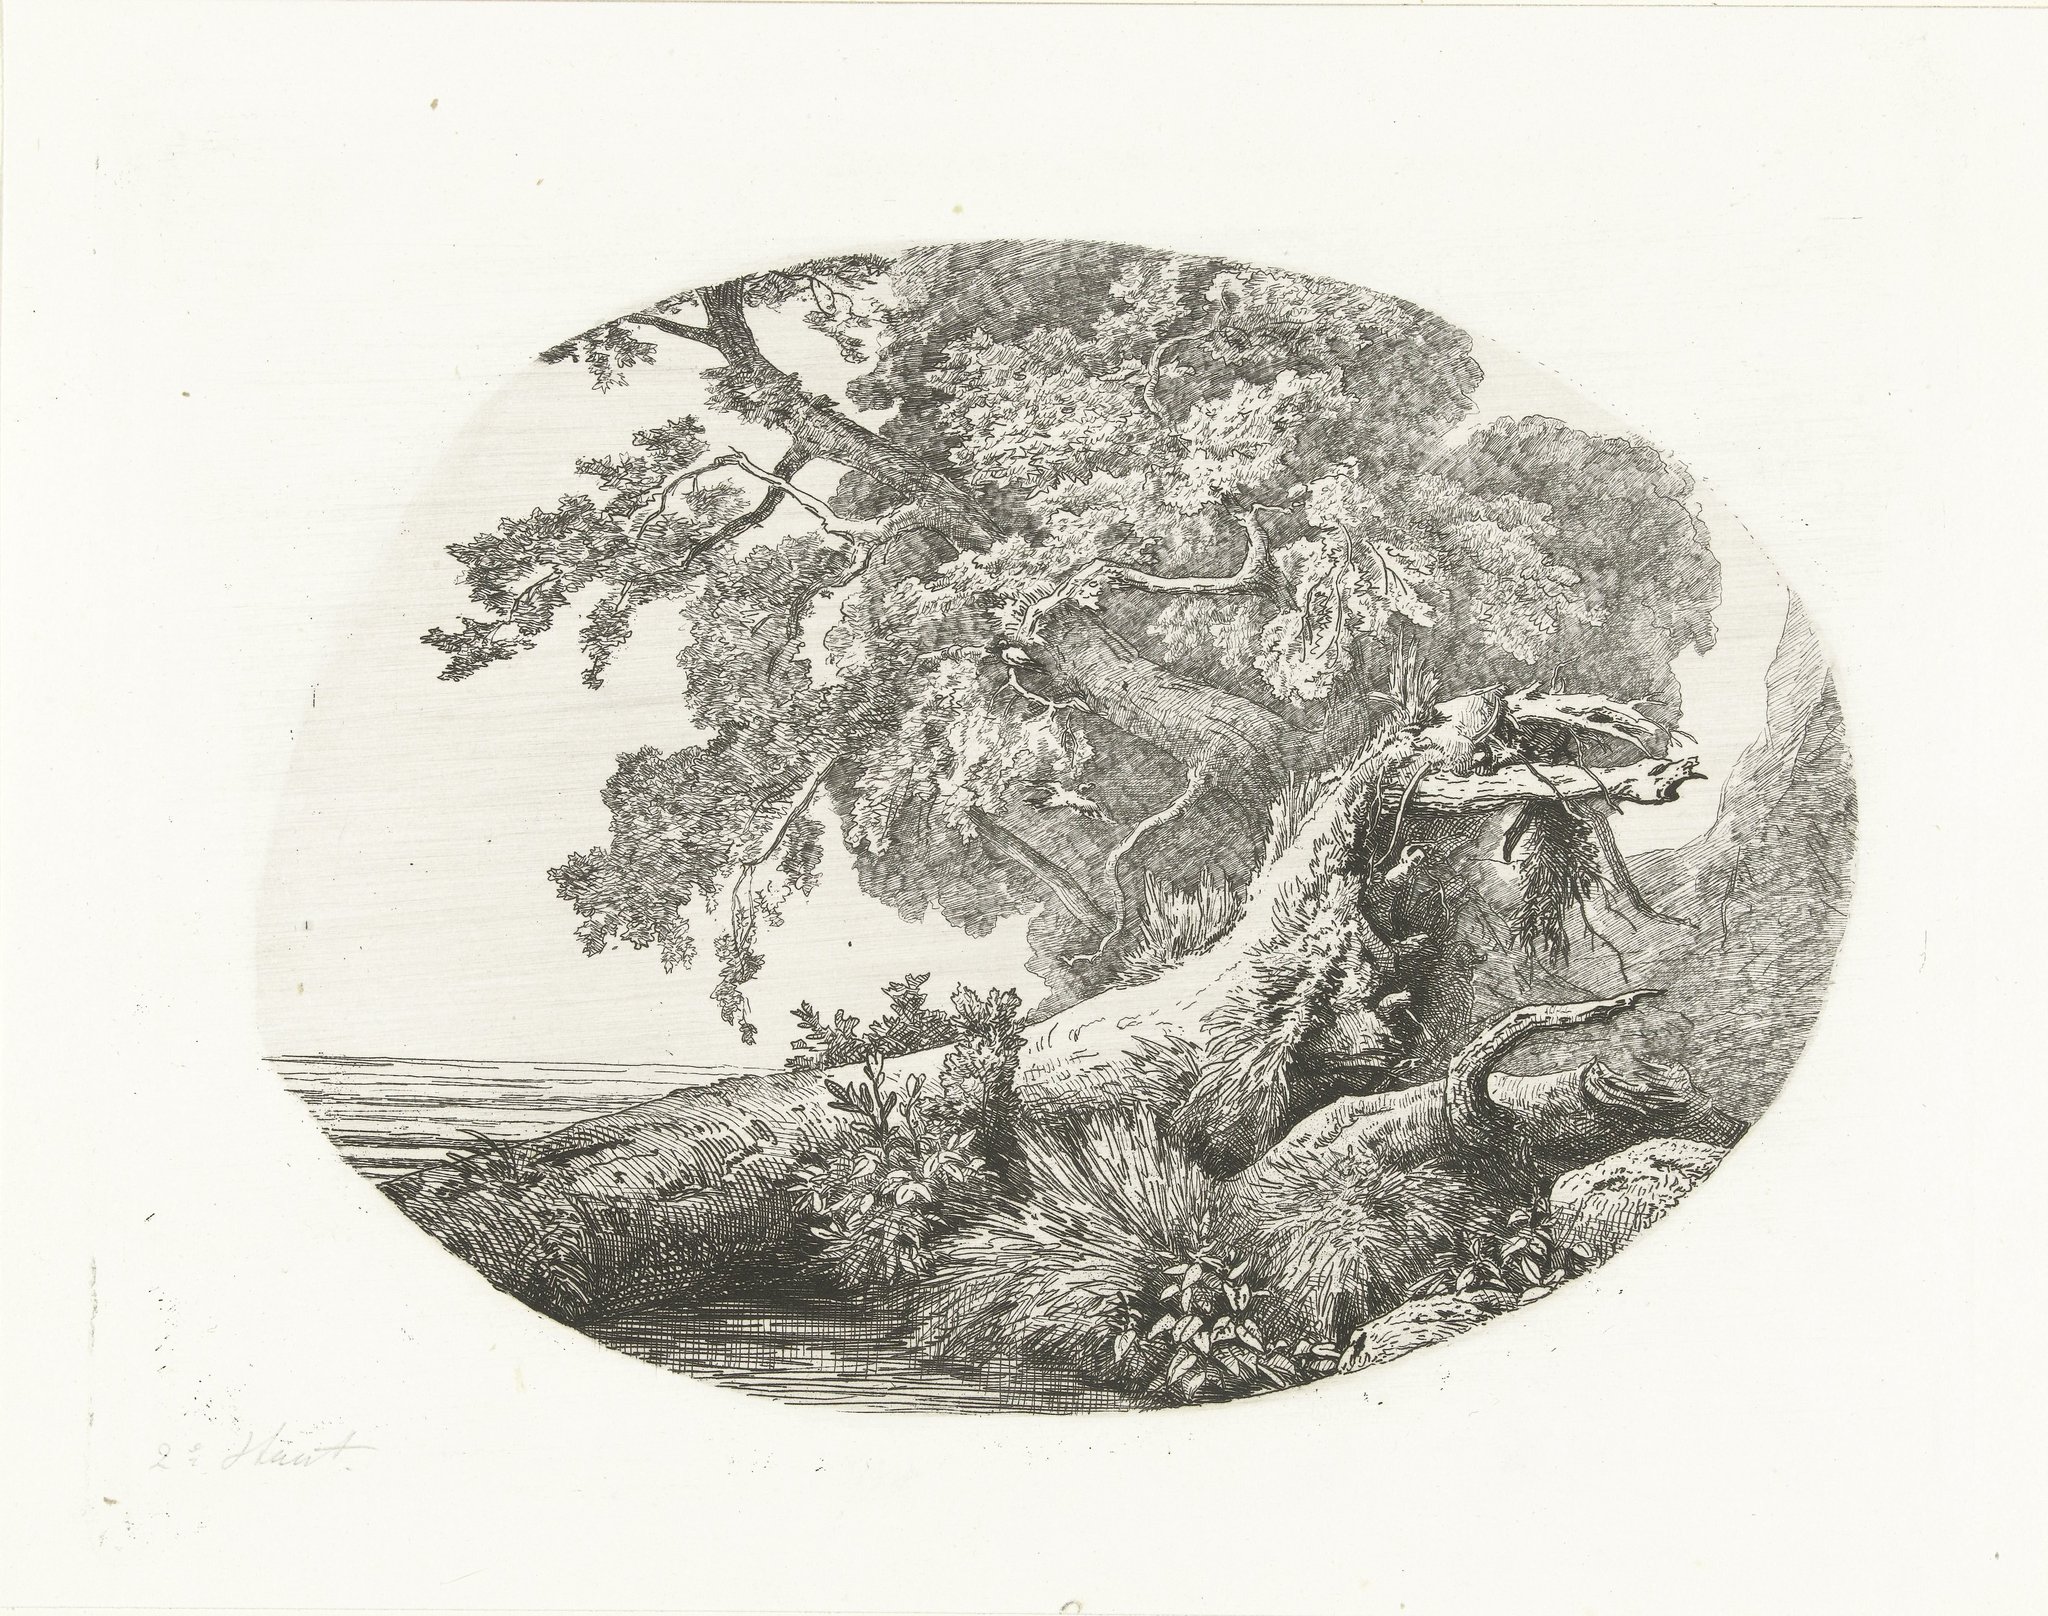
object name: print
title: Ontwortelde boomstam aan de kust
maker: pierre louis dubourcq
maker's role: draughtsman, painter, print maker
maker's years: 1815-1873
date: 1854-1856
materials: paper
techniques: etching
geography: netherlands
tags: groups of trees, mountain-range, snow peaks, coast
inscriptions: collector's mark: Lugt 2228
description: Aan de kust van een meer ligt een ontwortelde boomstam. Aan de overkant zijn sneeuwbedekte bergtoppen te zien.